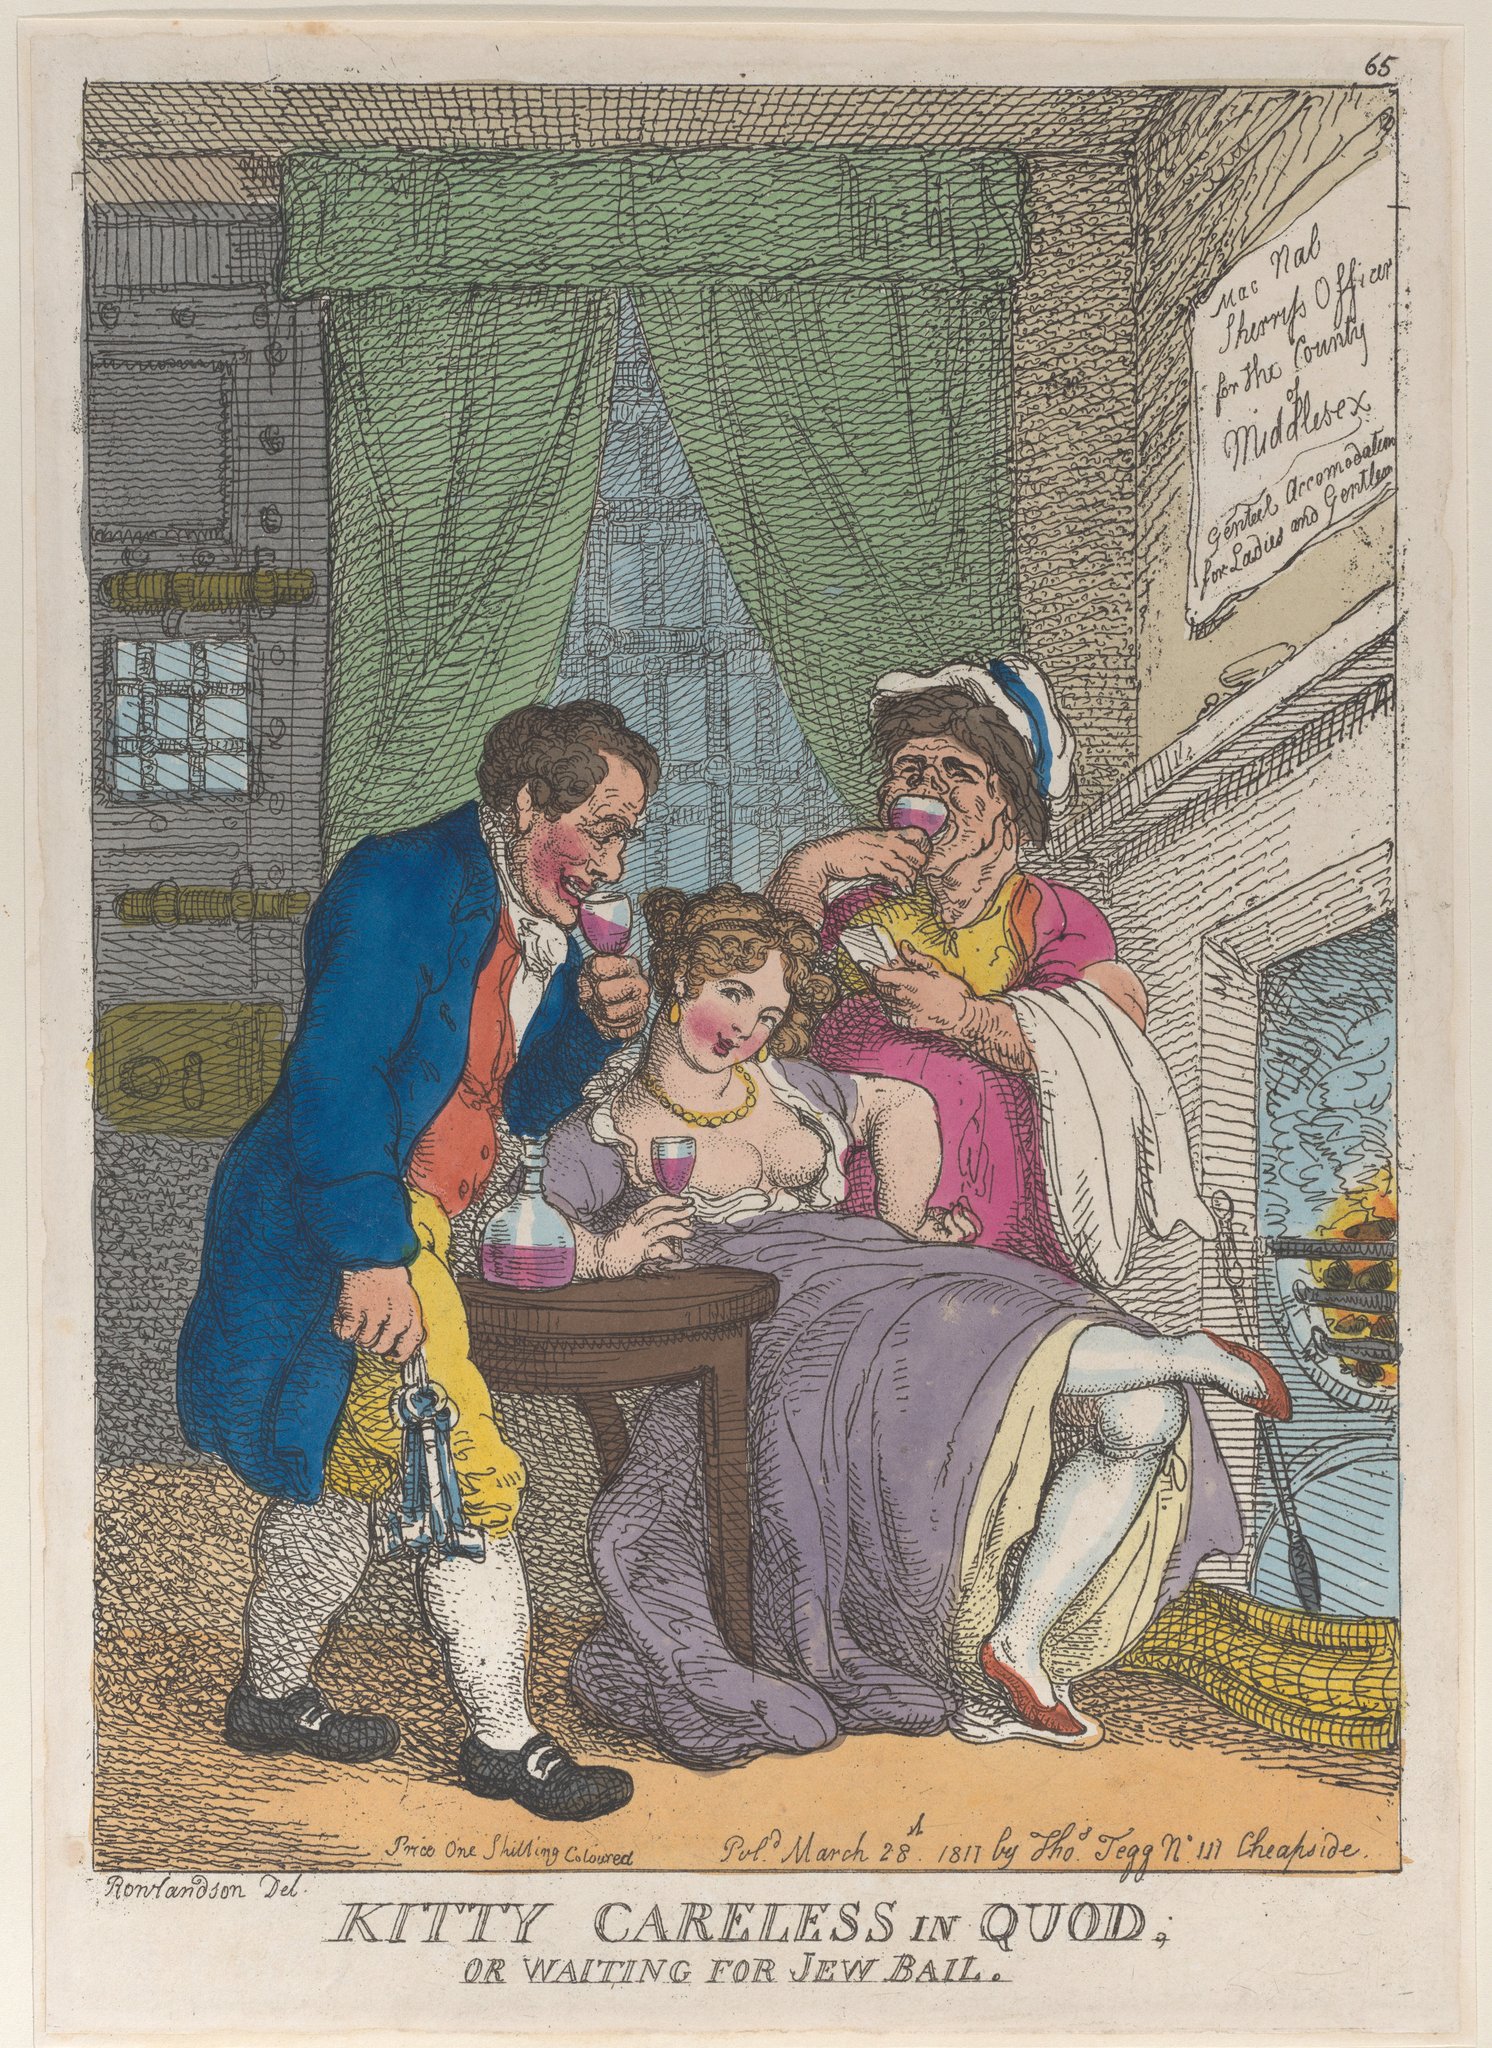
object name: print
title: Kitty Careless in Quod or Waiting for Jew Bail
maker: thomas rowlandson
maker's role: artist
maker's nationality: british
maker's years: 1757-1827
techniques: etching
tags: satire,men,women,drinking